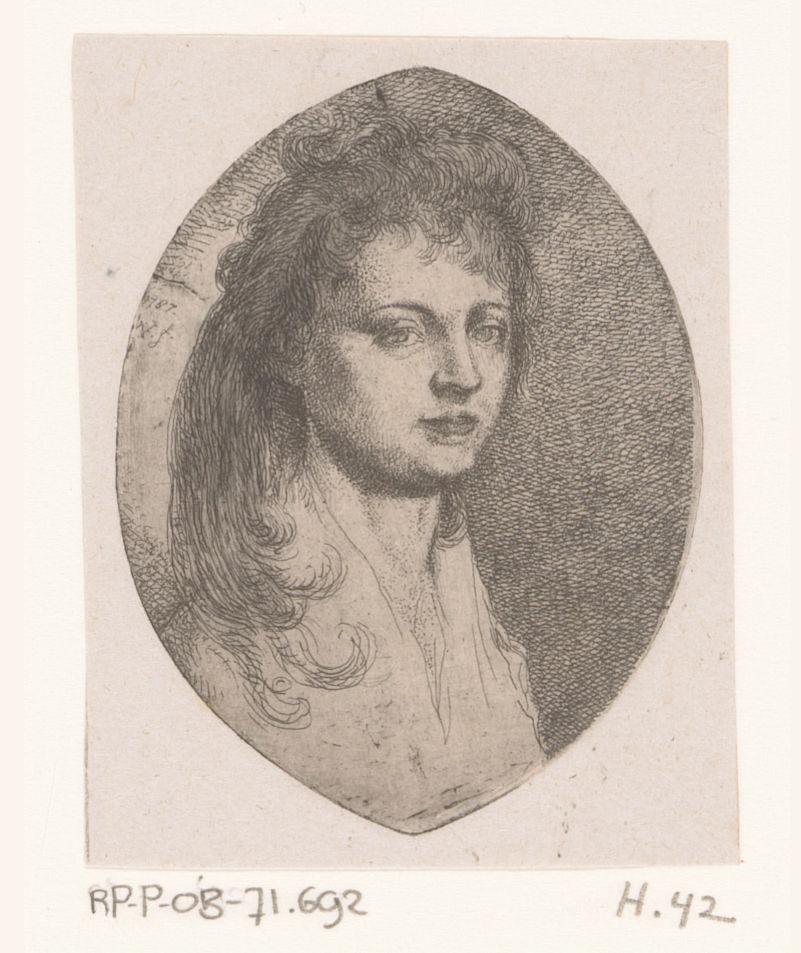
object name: print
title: Portret van Marianna Tokarska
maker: jean pierre norblin de la gourdaine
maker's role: print maker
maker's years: 1745-1830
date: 1787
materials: paper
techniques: etching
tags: historical persons - bb - woman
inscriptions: date